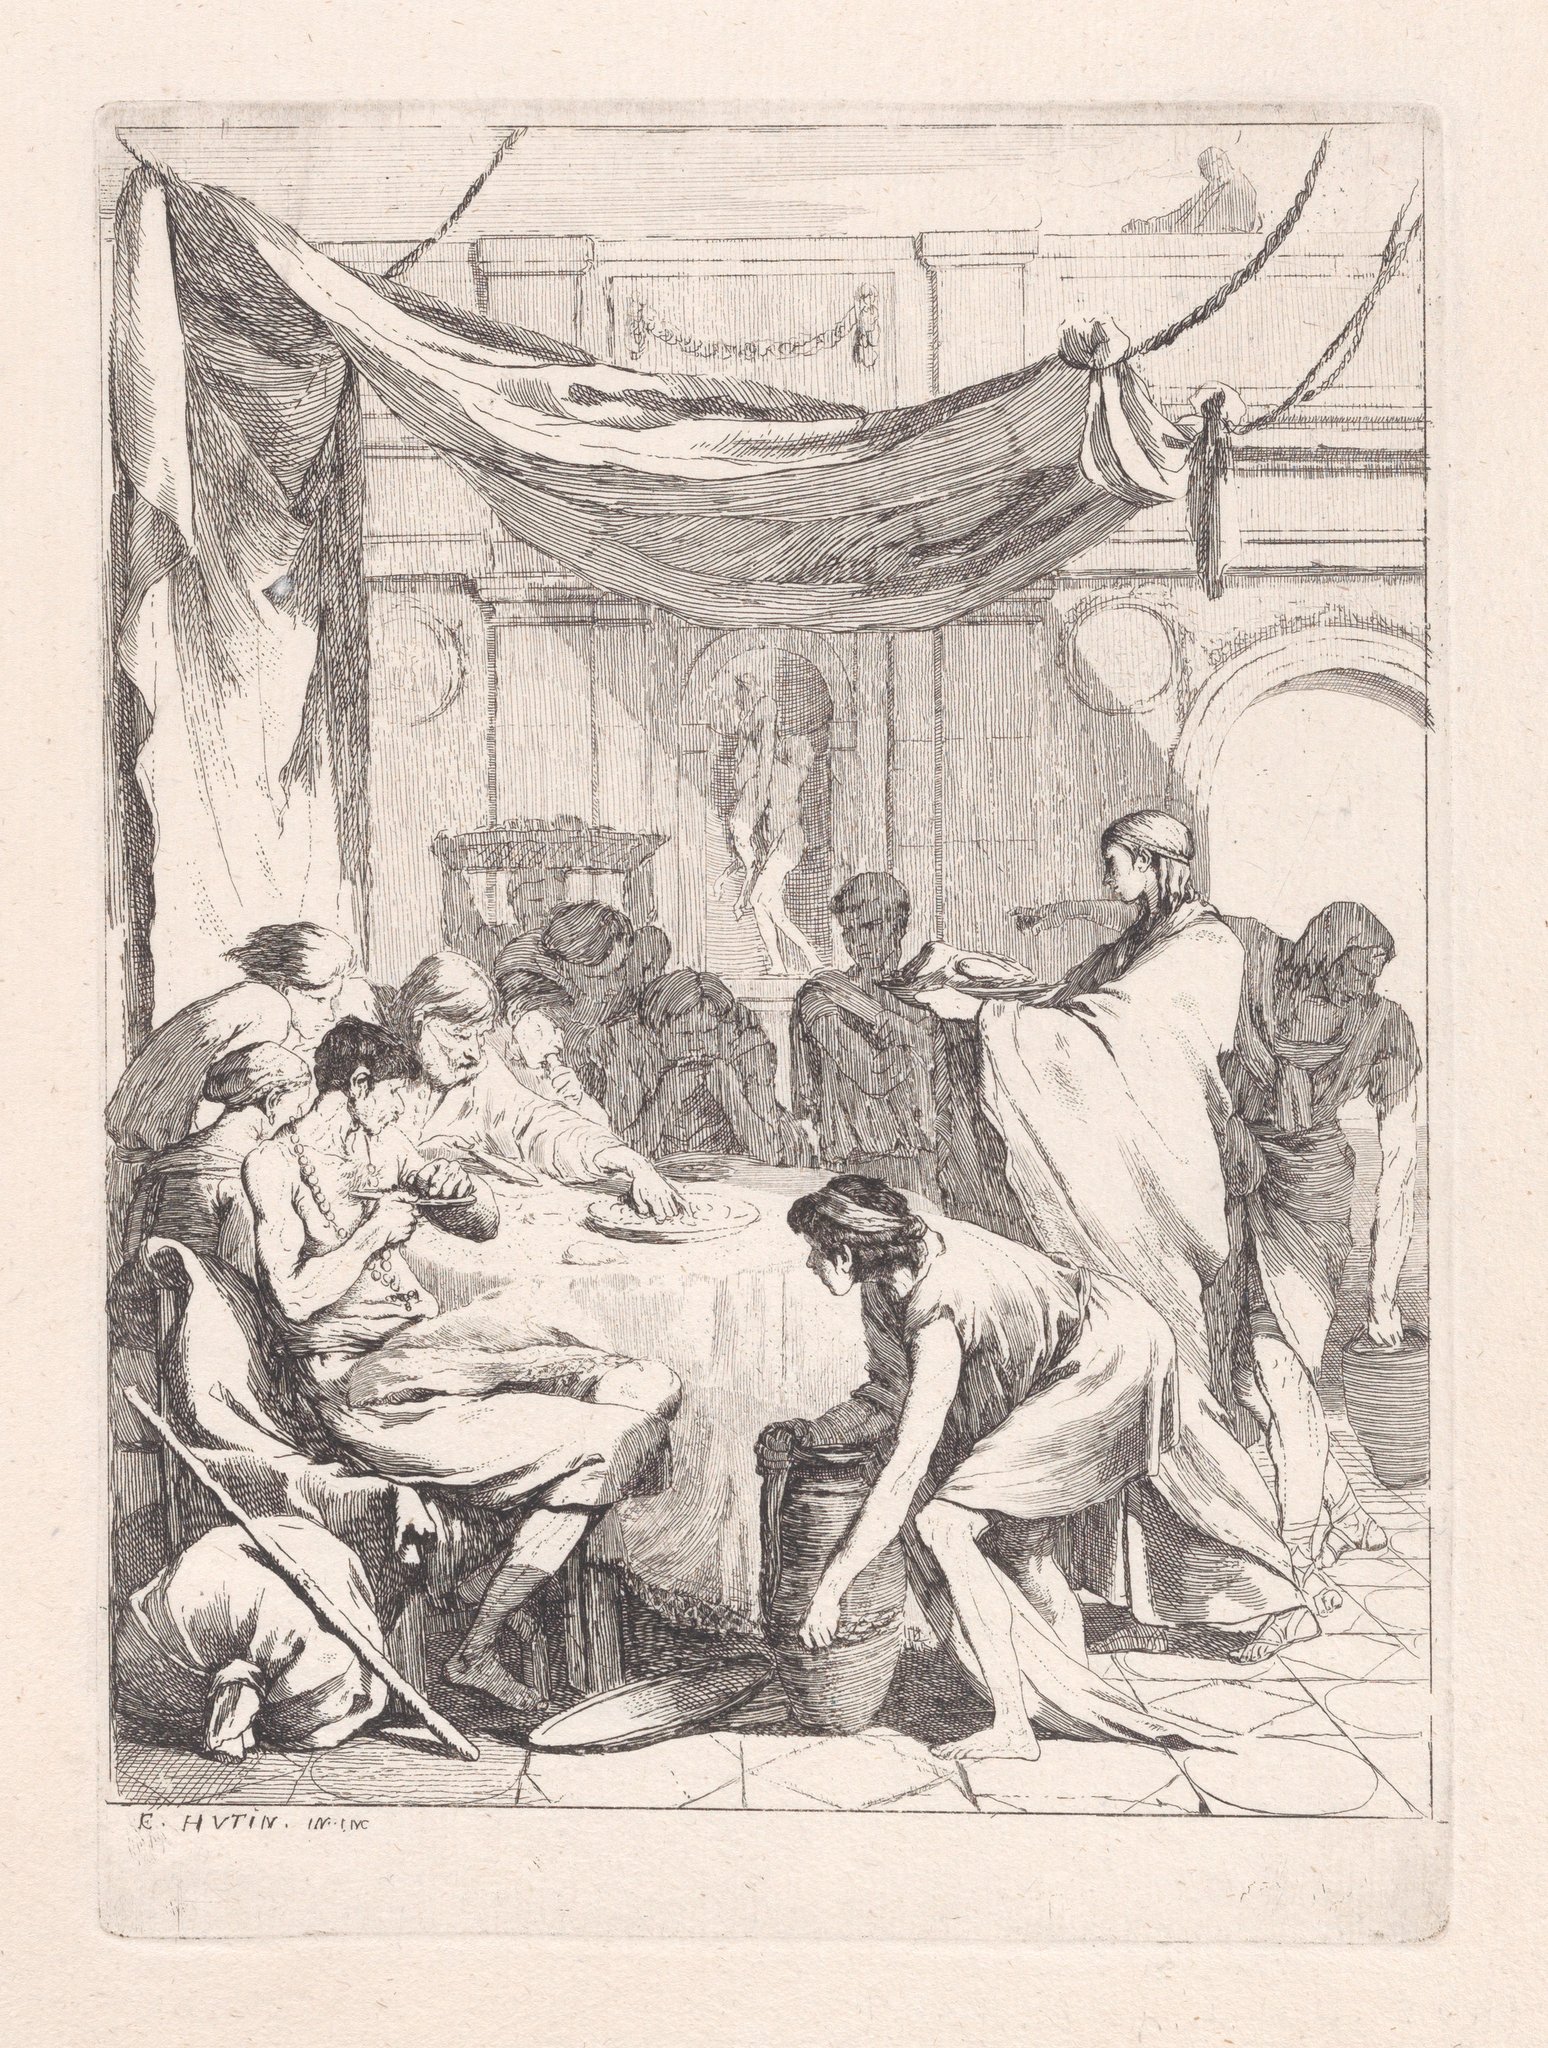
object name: print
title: Sheltering Strangers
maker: françois hutin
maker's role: artist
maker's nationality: french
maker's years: 1686-1758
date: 1737-1742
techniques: etching